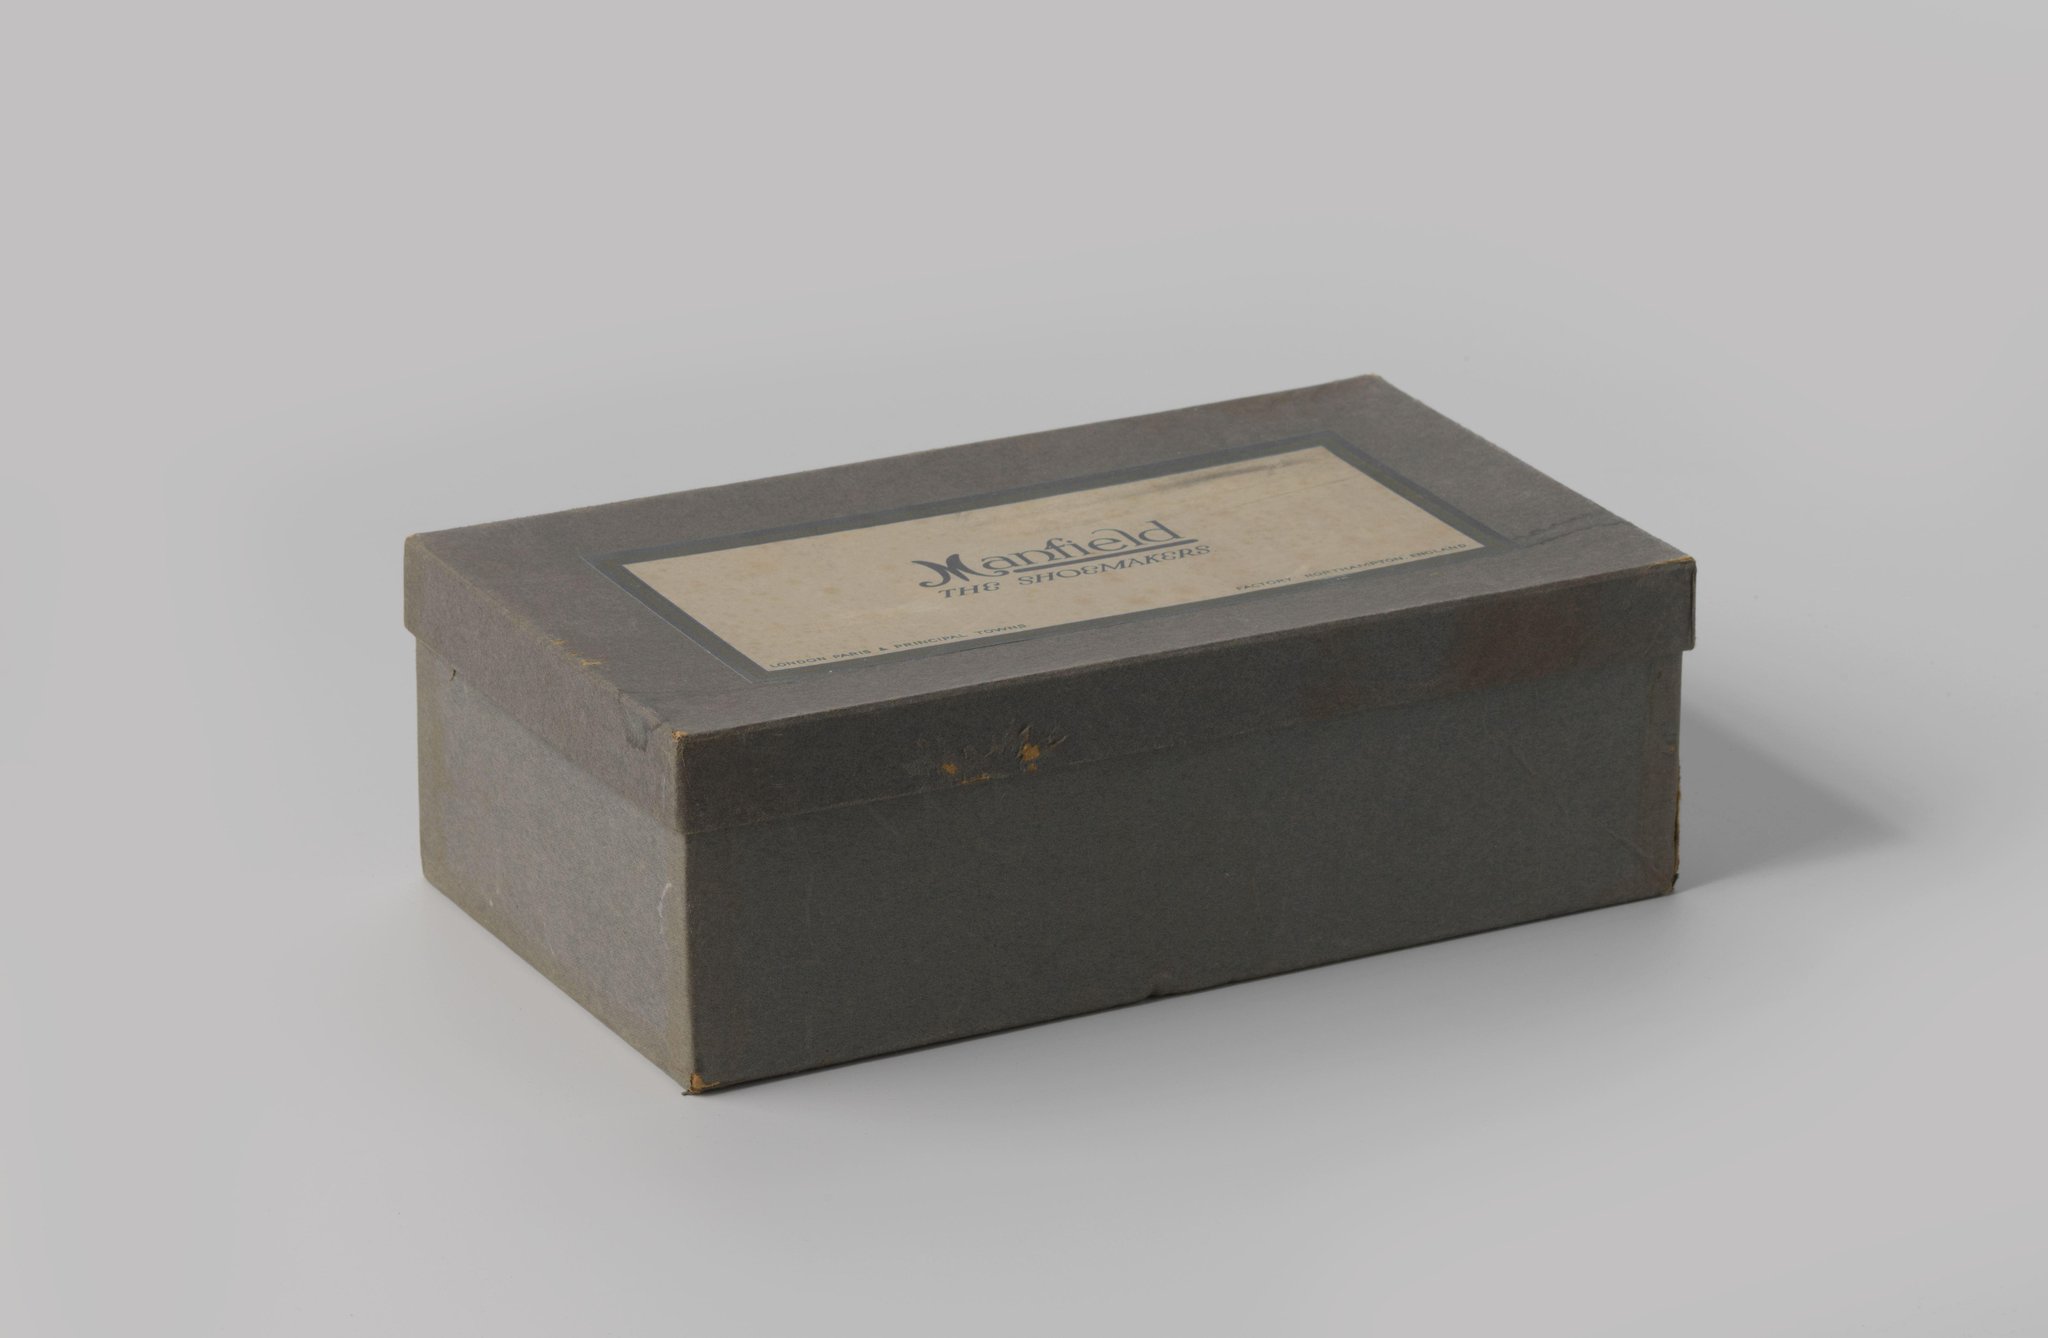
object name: packing material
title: Schoenendoos van paar avondschoenen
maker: Anonymous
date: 1928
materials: cardboard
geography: netherlands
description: Groene rechthoekige schoenendoos met deksel waarop de naam 'Manfield the shoemaker' staat.